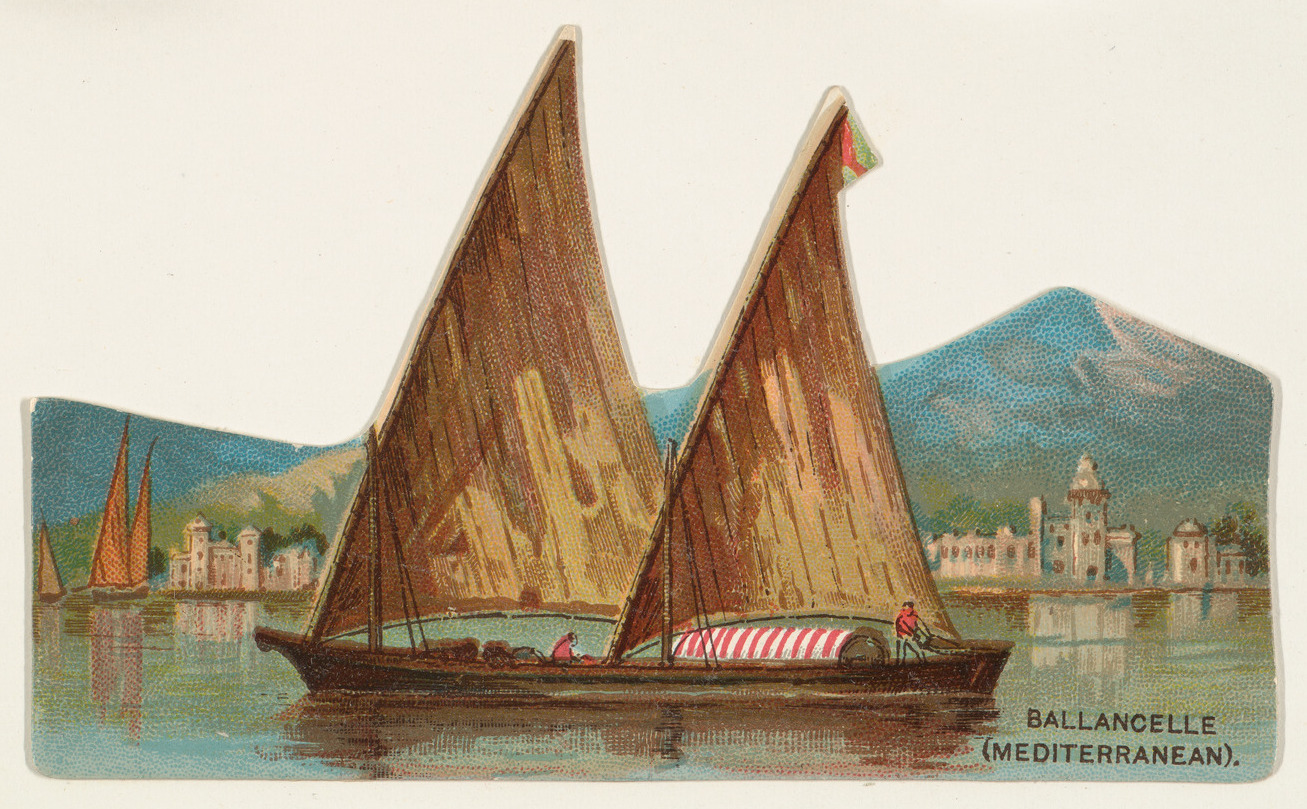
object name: print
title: Ballancelle (Mediterranean), from the Types of Vessels series (N139) issued by Duke Sons & Co. to promote Honest Long Cut Tobacco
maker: w. duke, sons & co.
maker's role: publisher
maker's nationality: american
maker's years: 1870-1920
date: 1889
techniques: color lithograph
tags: boats